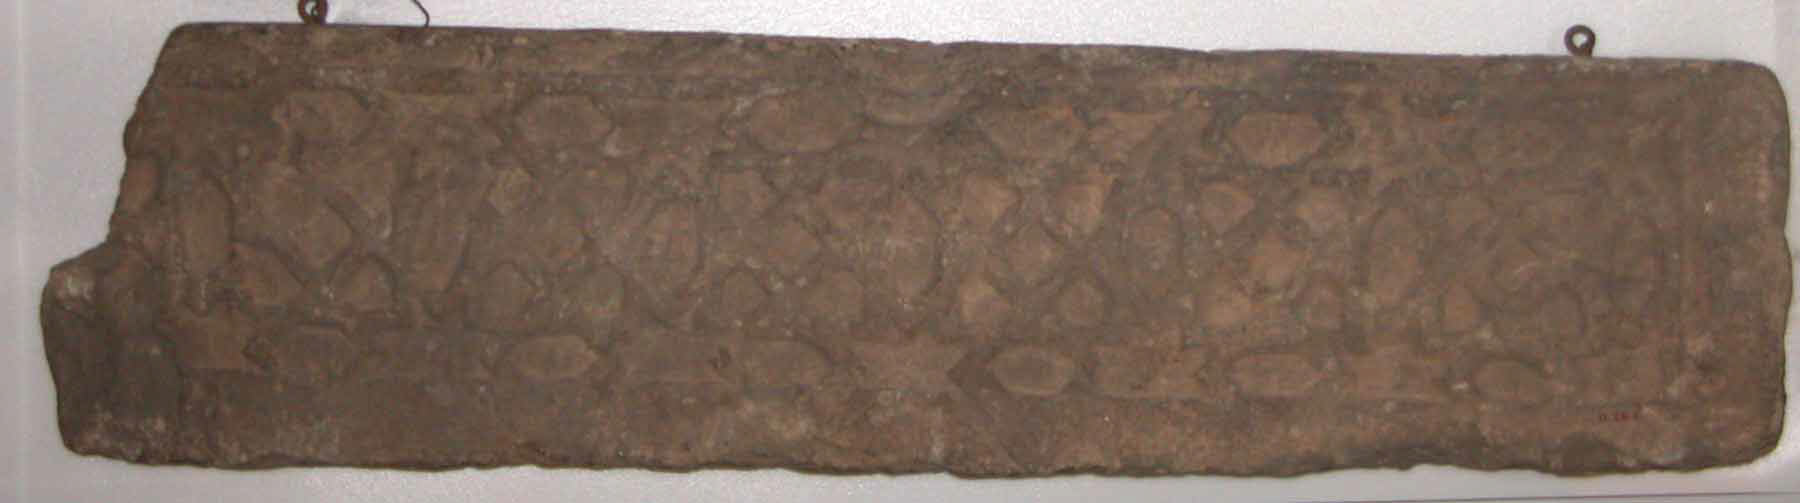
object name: slab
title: Carved Slab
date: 1301-1400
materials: stone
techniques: carving, relief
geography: spain